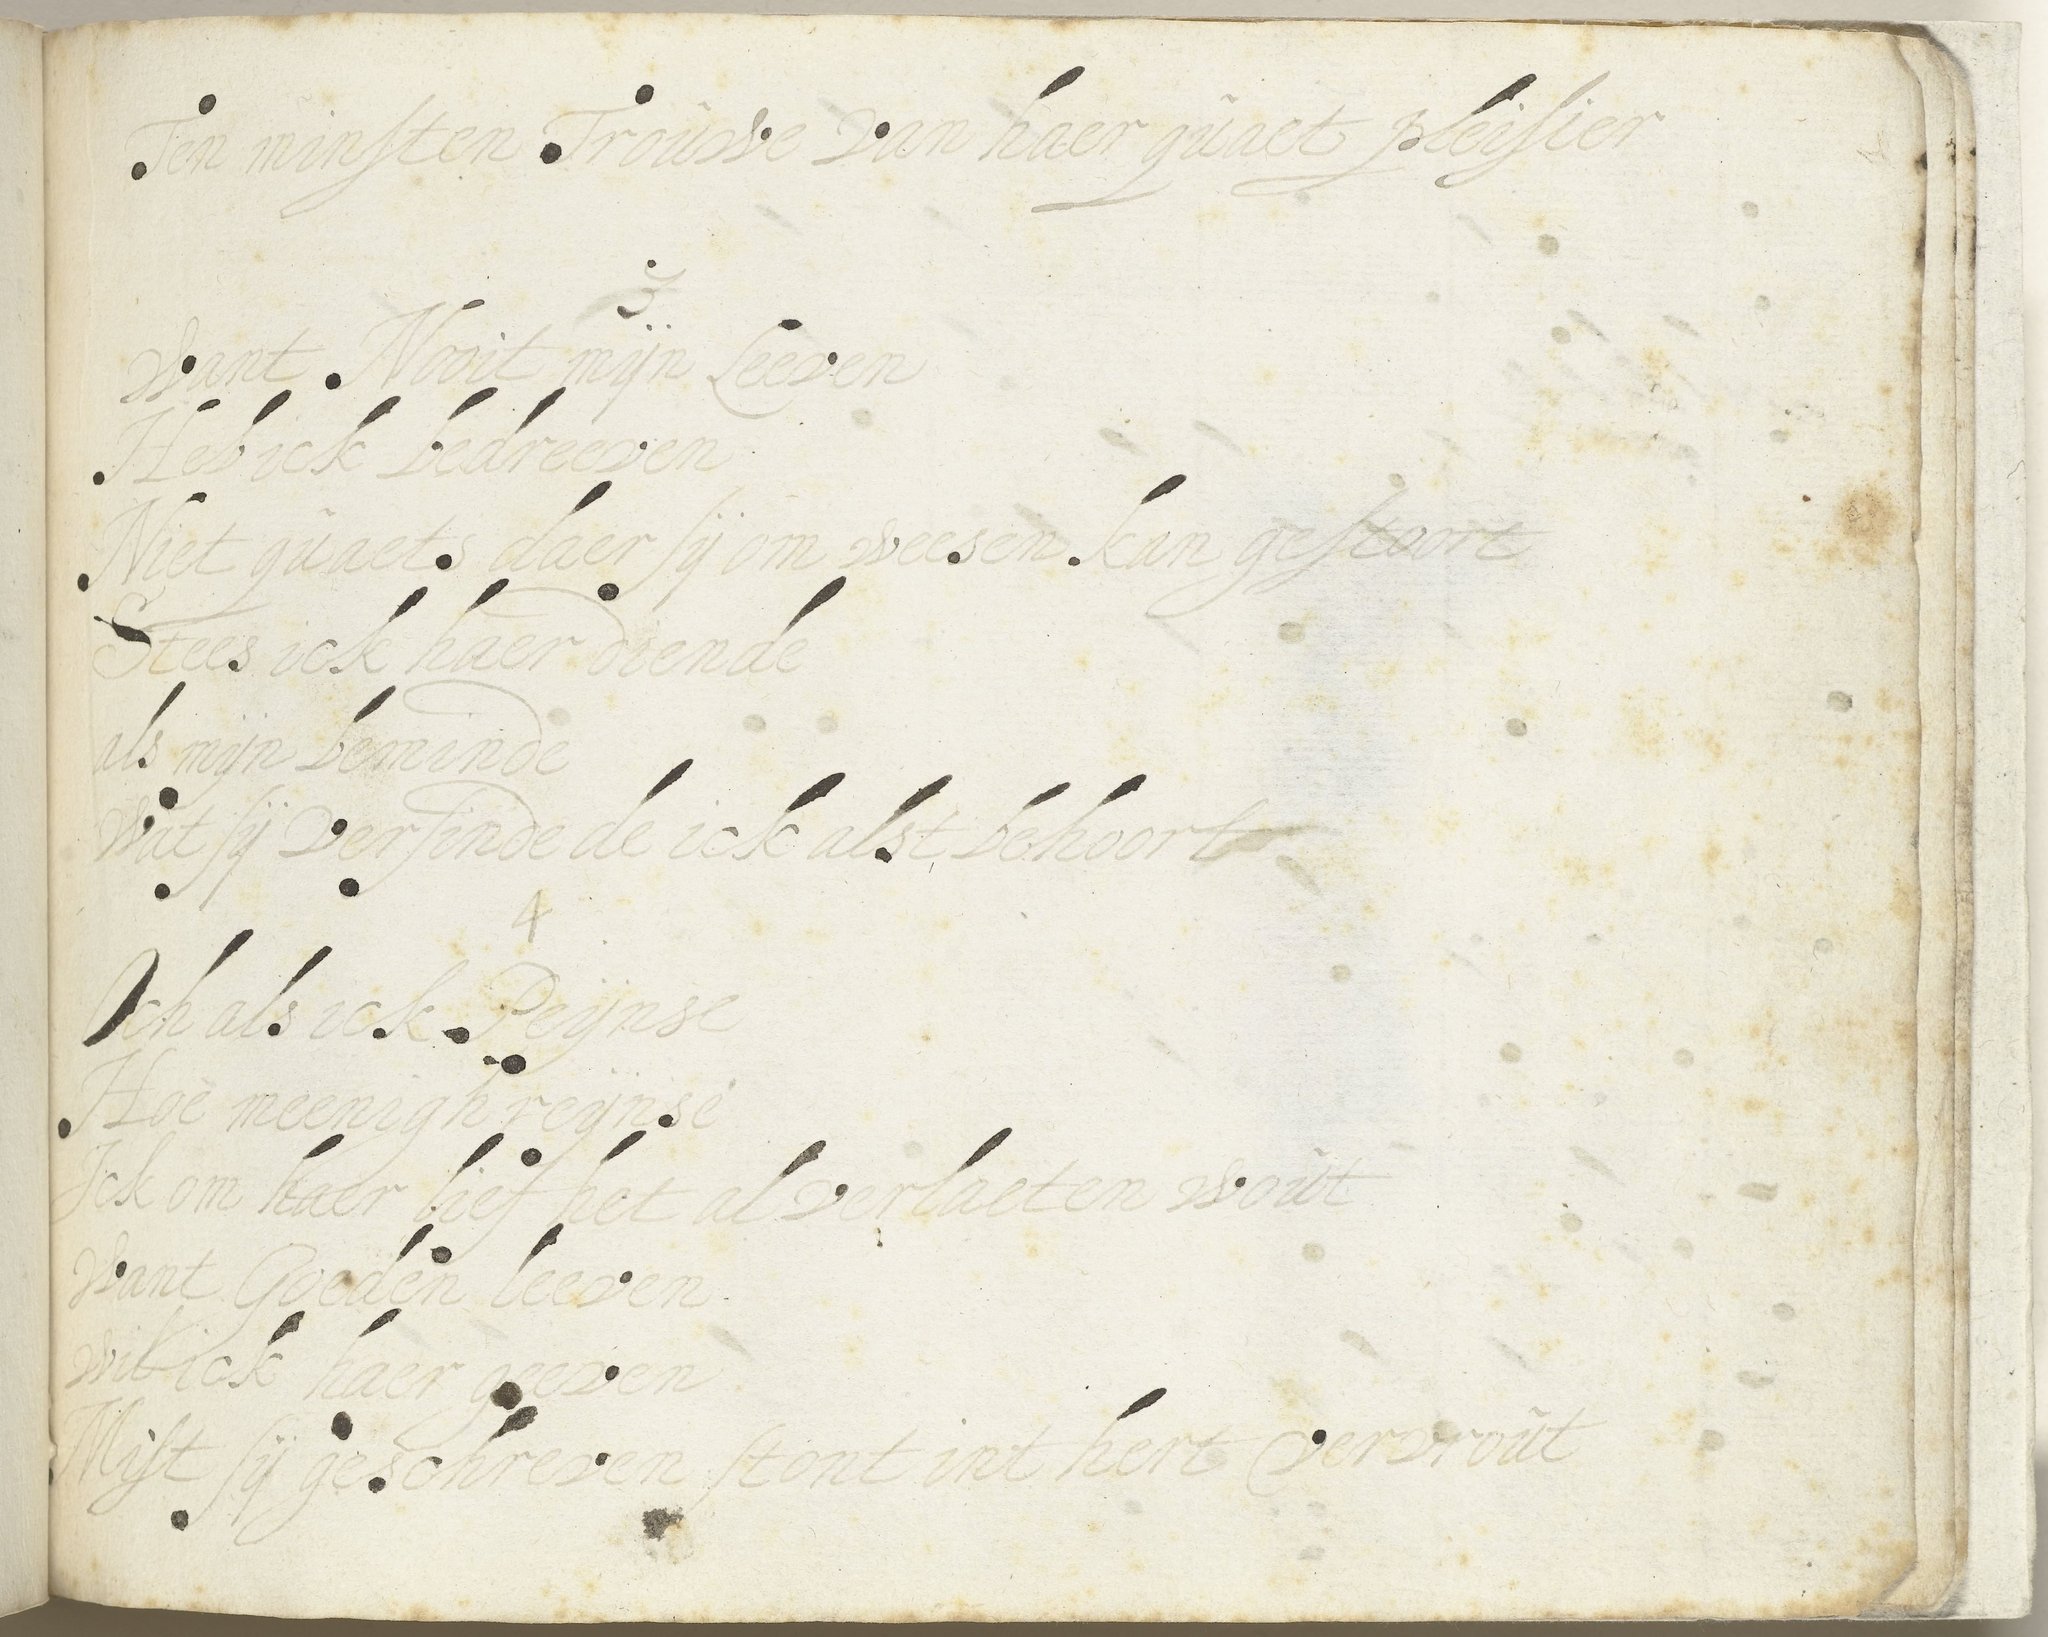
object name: calligraphy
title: Gedicht over een heer die verliefd is geworden op iemand boven zijn stand (deel 2)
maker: gesina ter borch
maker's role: draughtsman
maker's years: 1633-1690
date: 1646-1650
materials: ink, paper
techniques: calligraphy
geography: zwolle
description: Vervolg van gedicht op de vorige pagina (verso van folio 23).